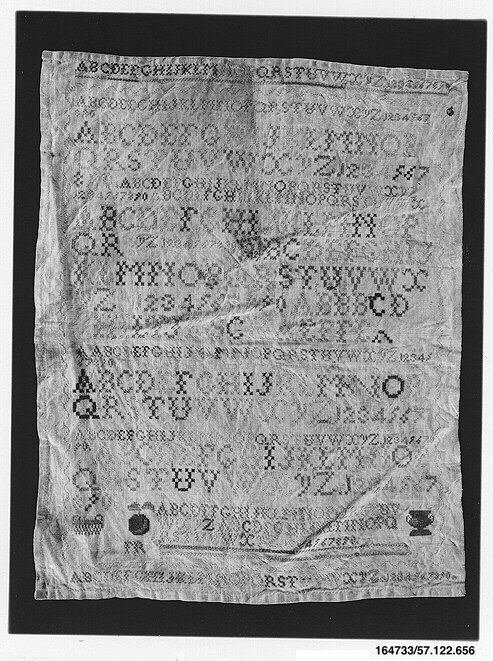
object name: sampler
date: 1801-1900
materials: linen, silk